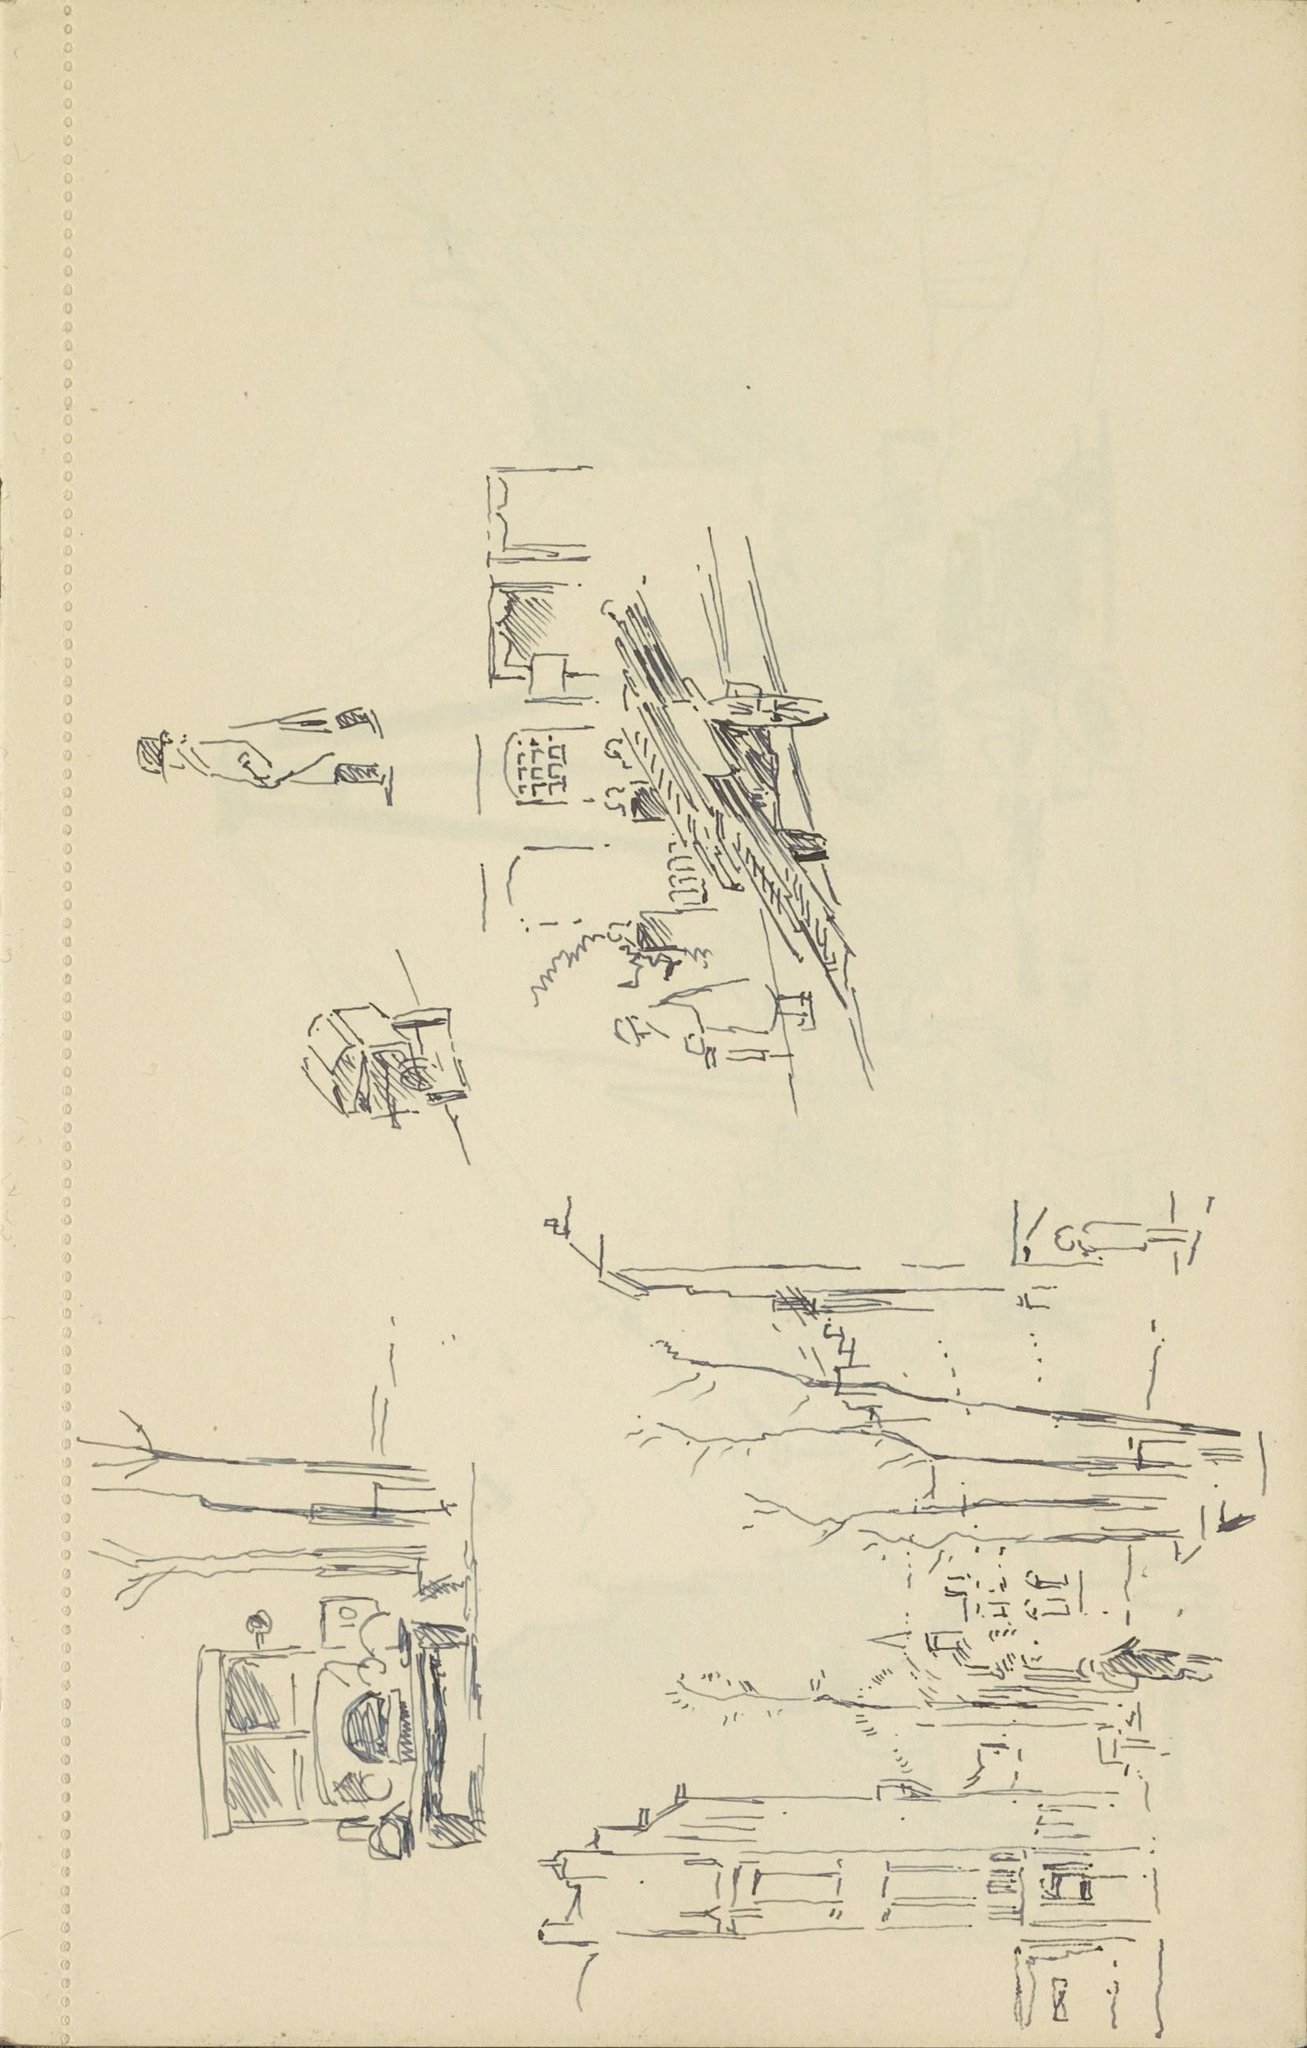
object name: sketchbook leaf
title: Studieblad, onder andere met een straatgezicht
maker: cornelis vreedenburgh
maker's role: draughtsman, print maker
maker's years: 1880-1946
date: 1890-1946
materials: ink, paper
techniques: pen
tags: hand-cart, automobile, street (+ city(-scape) with figures, staffage)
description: Tevens studies van een auto en beladen kar op een straat en een wandelende man. Blad 2 recto uit een schetsboek met 73 bladen.